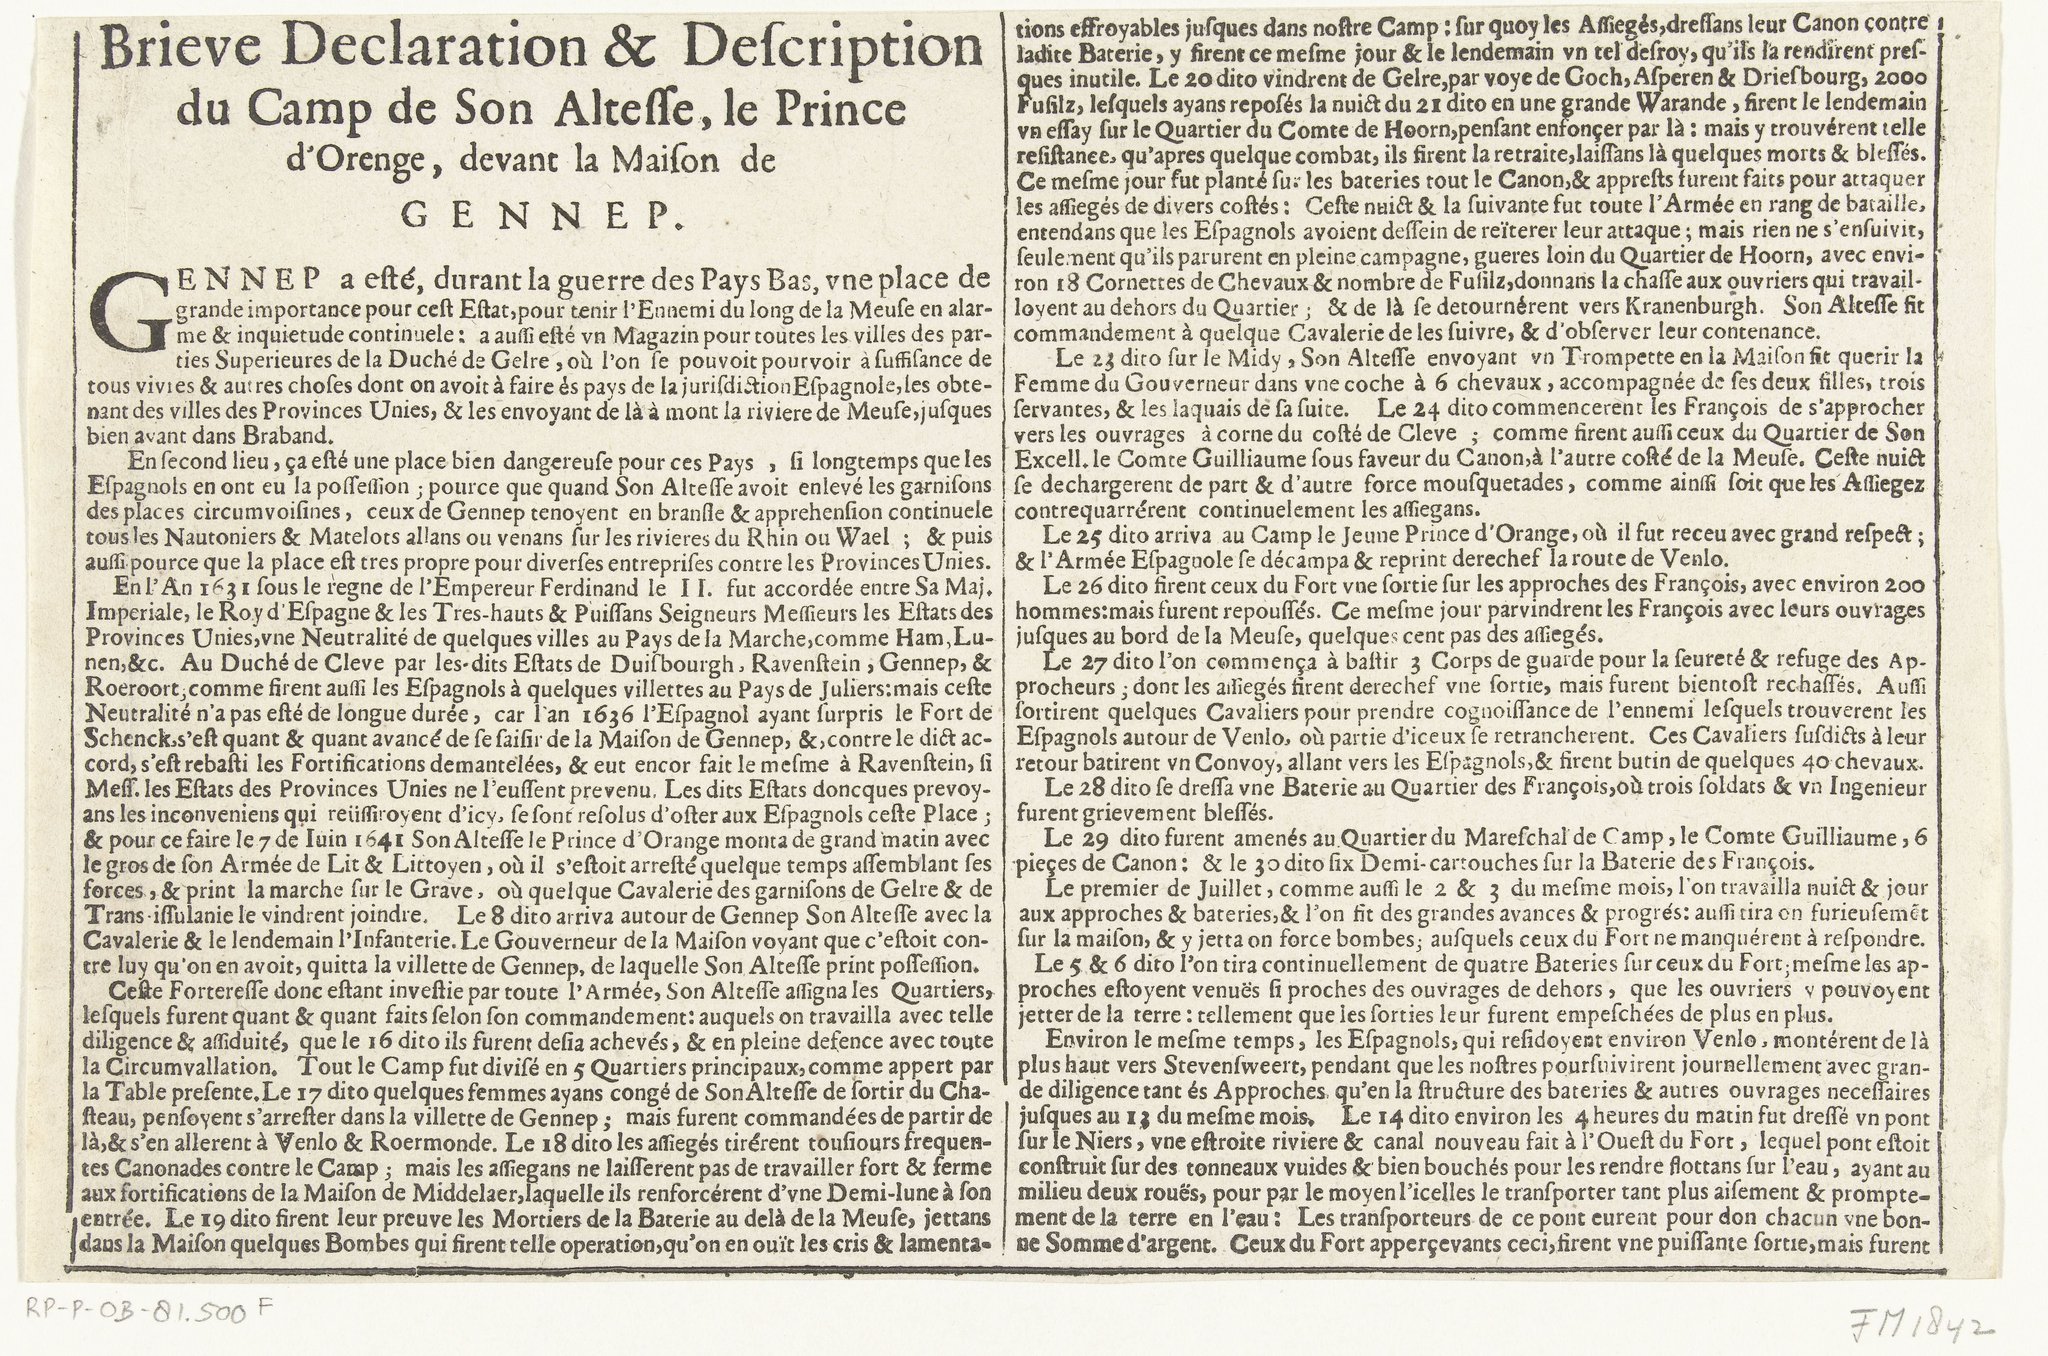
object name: print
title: Kaart van het beleg van Huis te Gennep (tekstblad), 1641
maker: claes jansz. visscher (ii)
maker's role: draughtsman, print maker, publisher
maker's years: 1586-1652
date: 1641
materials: paper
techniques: letterpress printing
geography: amsterdam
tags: delft, frederick henry (prince of orange)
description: Tekstblad bij de kaart van Gennep met het Huis te Gennep en omgeving, belegerd en veroverd door het Staatse leger onder Frederik Hendrik, 6 juni - 27 juli 1641. Tekst in 2 kolommen in het Frans. Onderdeel van een ensemble bestaande uit een titel in 4 stroken, de 4 platen uit het atelier van Visscher, de 4 bladen van het vertrek van het garnizoen door Nolpe en 7 tekstbladen.